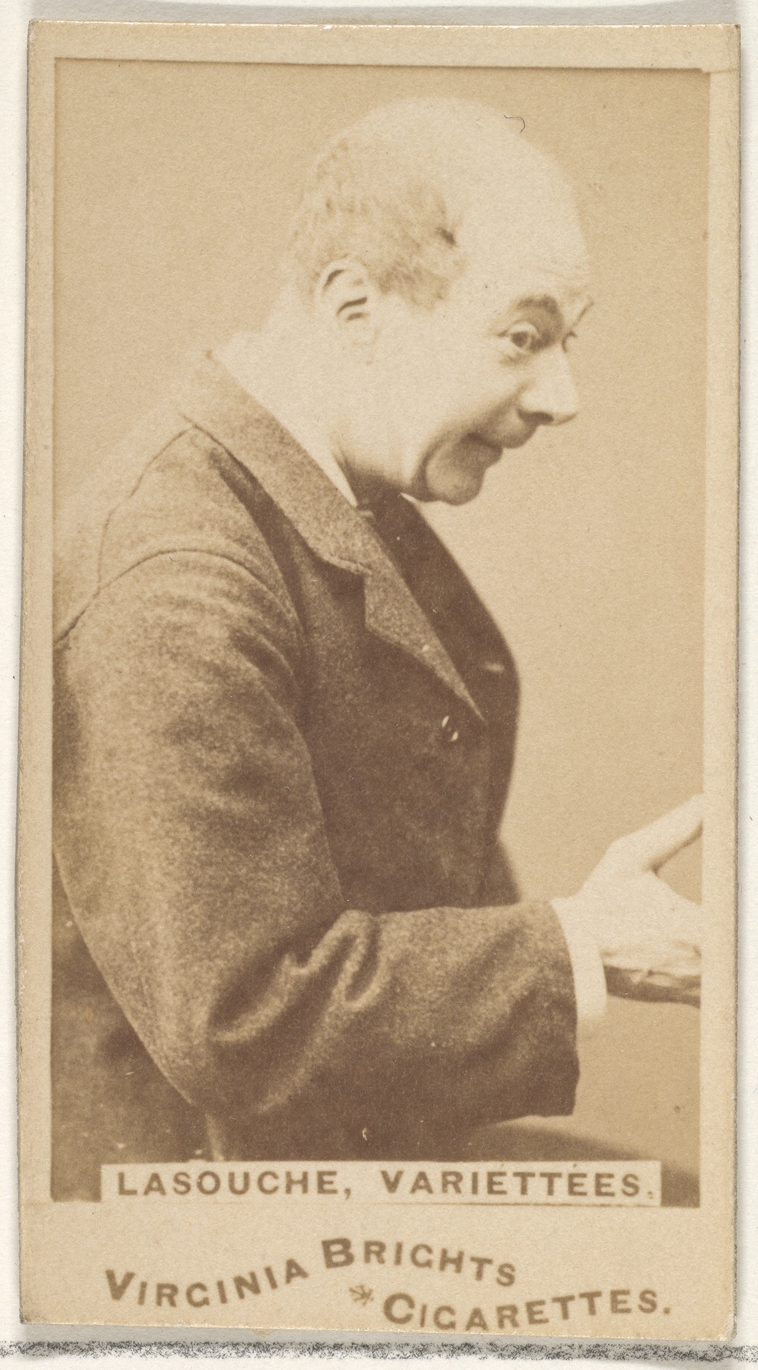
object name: photograph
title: Lasouche, Variettees, from the Actors and Actresses series (N45, Type 1) for Virginia Brights Cigarettes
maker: allen & ginter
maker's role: publisher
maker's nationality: american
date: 1888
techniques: albumen silver print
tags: men,portraits,actors